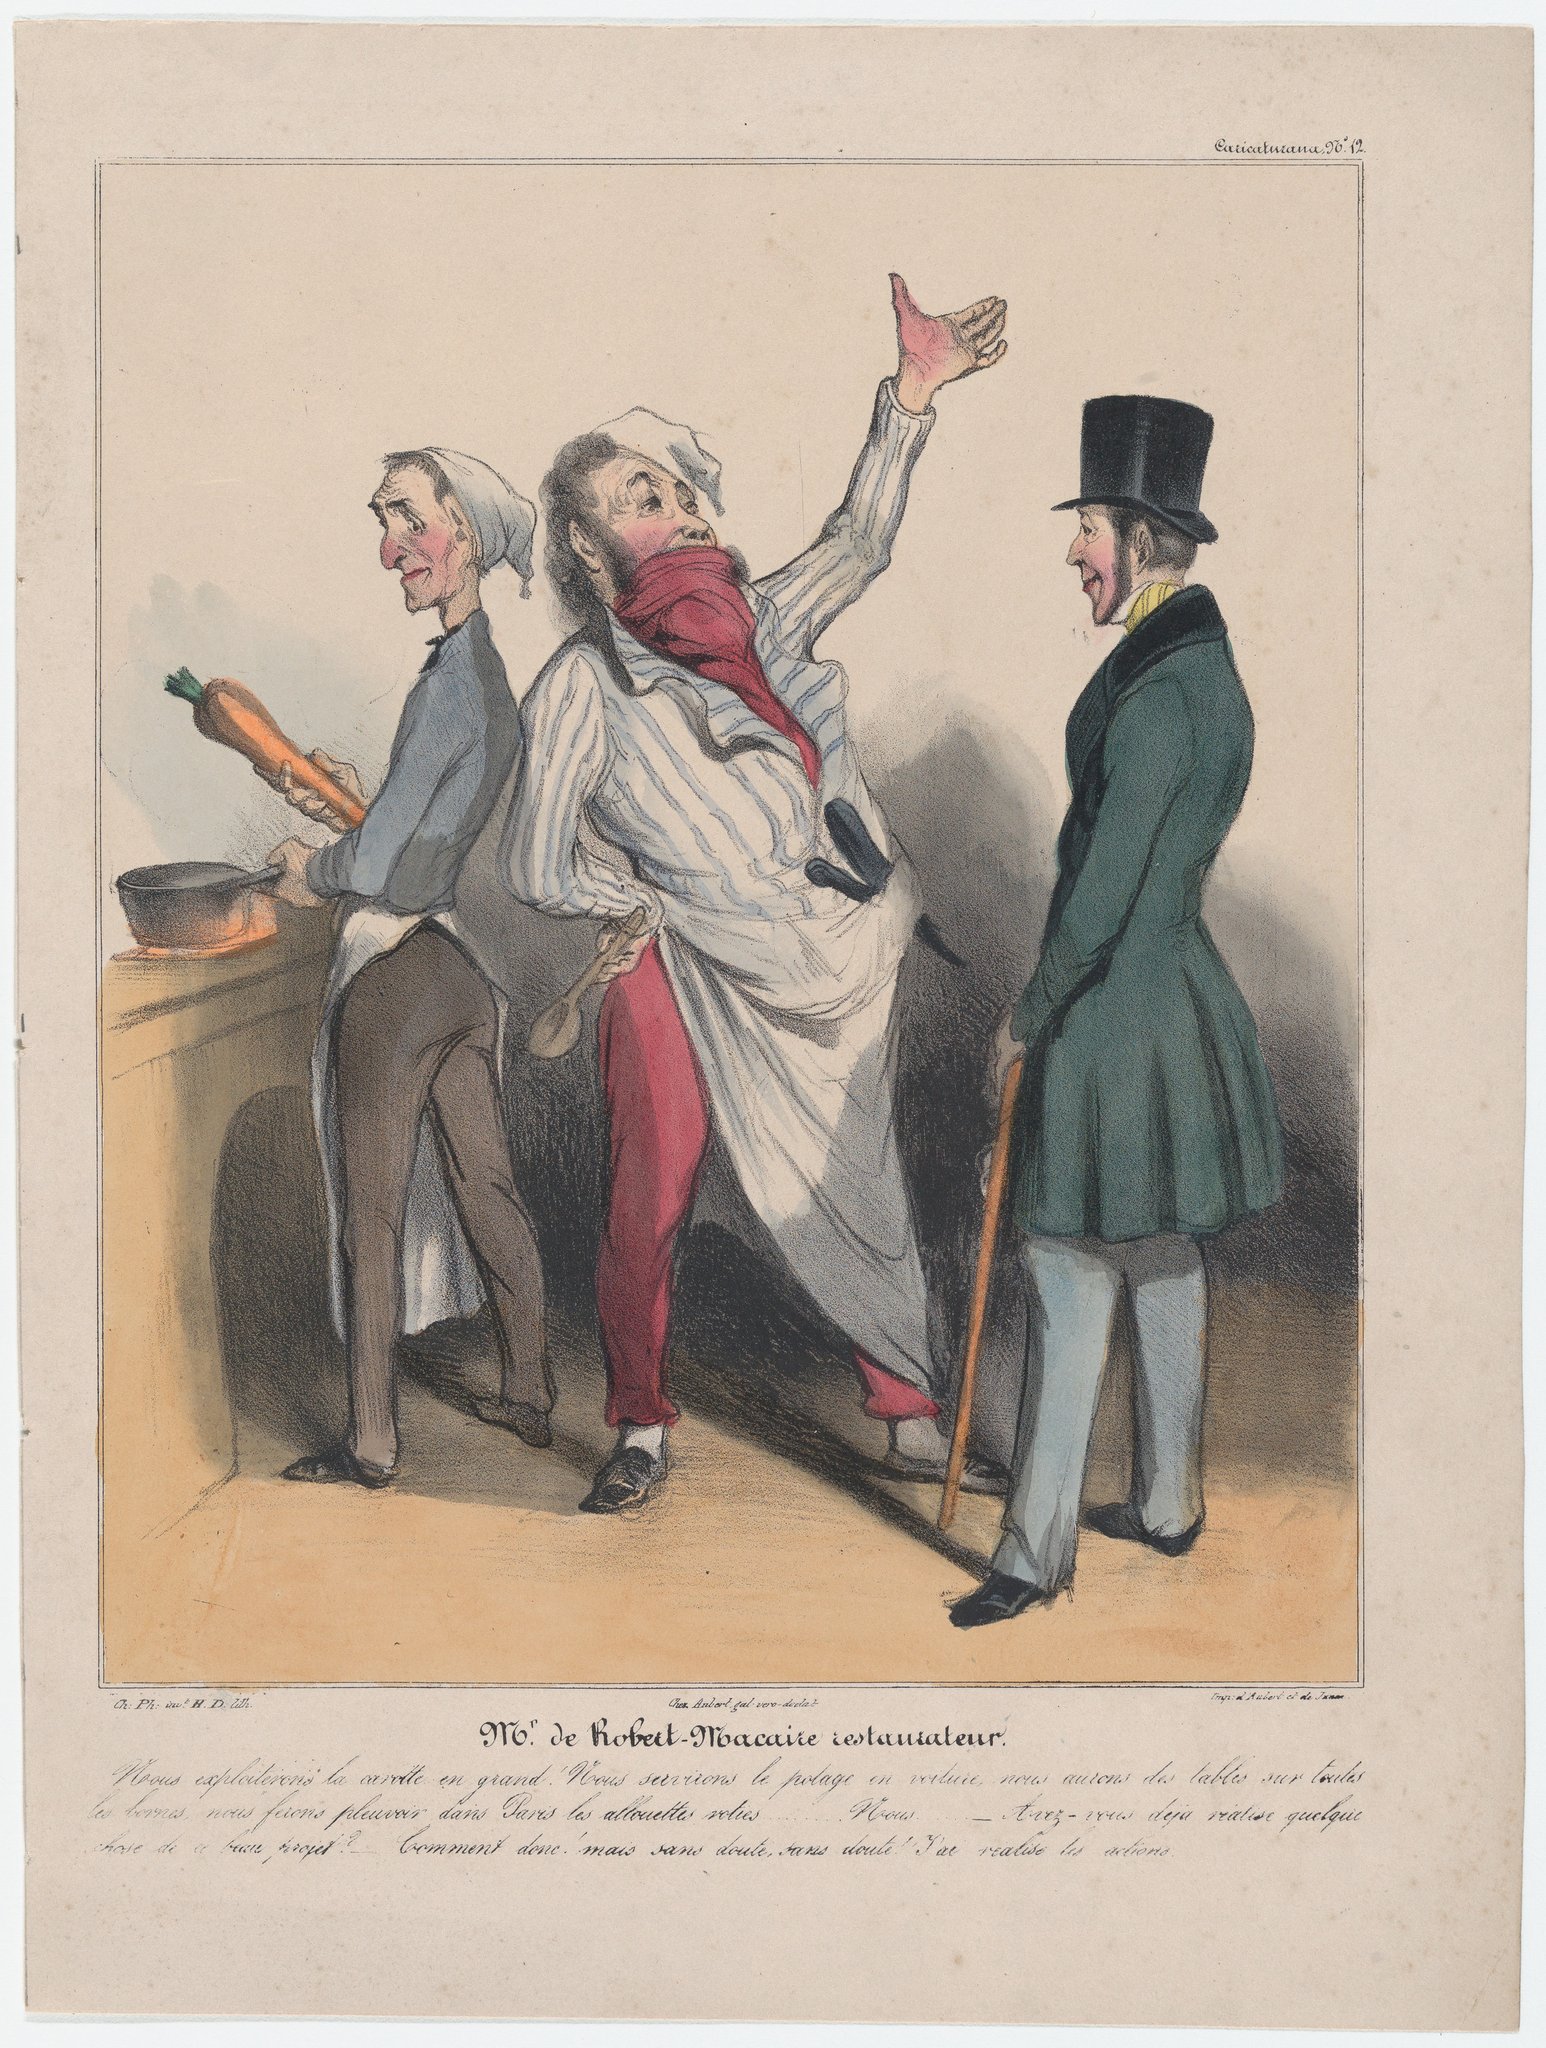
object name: print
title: Plate 12: Mr. de Robert Macaire, restauranteur, from 'Caricaturana,' published in Les Robert Macaires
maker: honoré daumier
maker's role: artist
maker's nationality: french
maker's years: 1808-1879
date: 1838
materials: paper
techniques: lithograph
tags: men